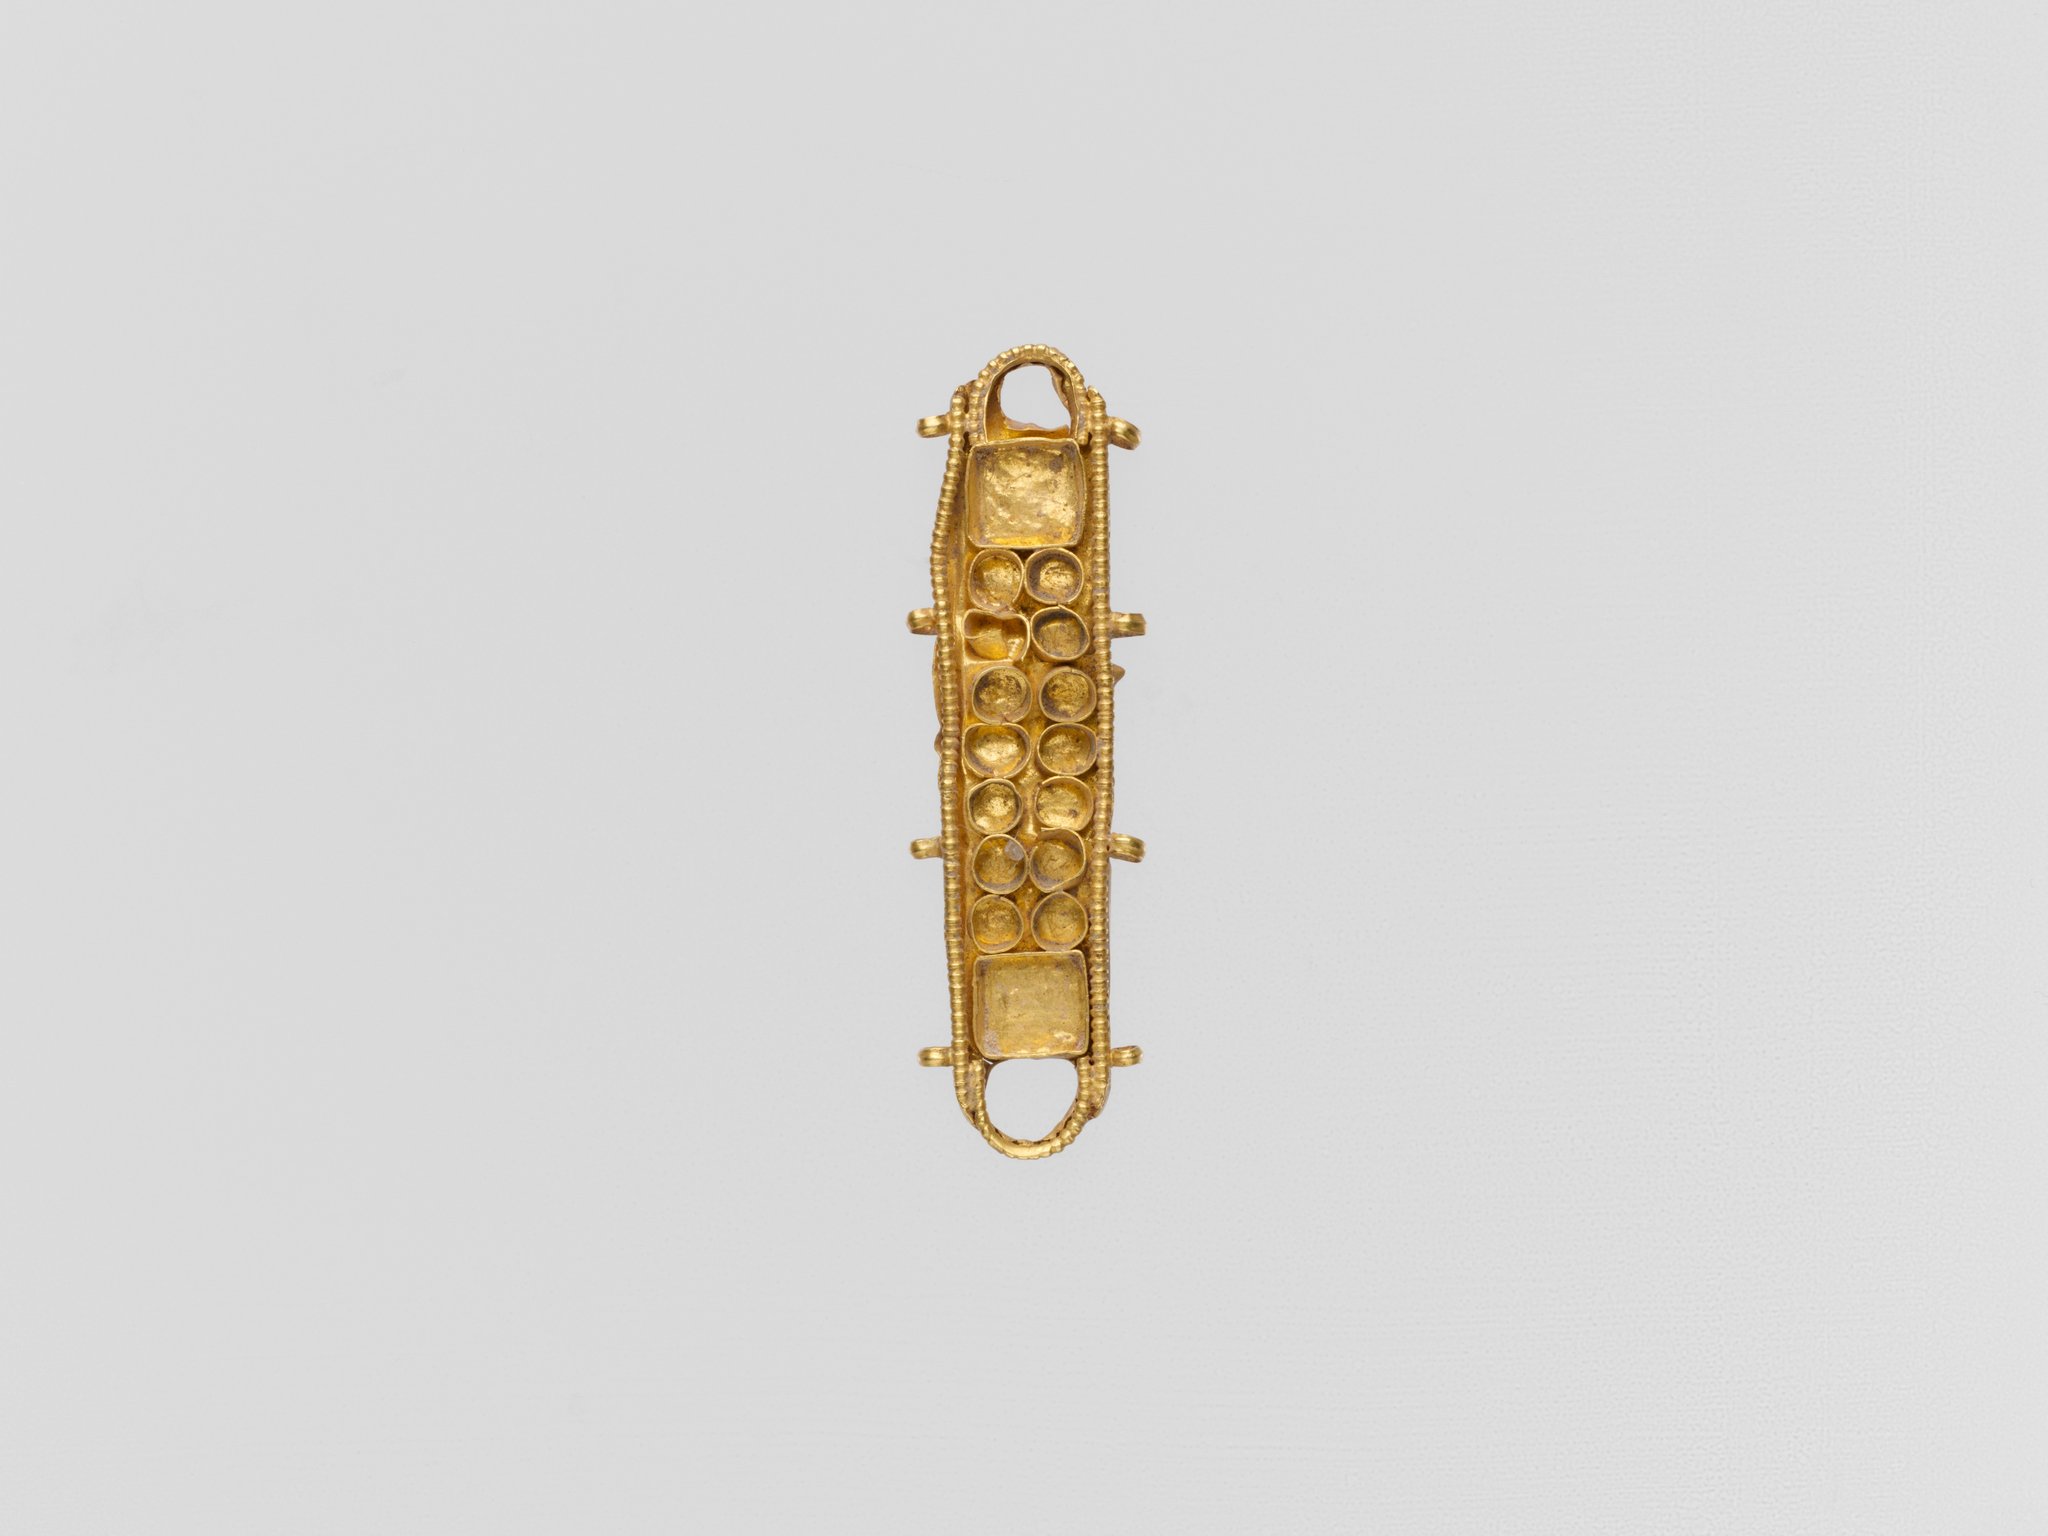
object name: bead ornament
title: Gold ornament with cloisons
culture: roman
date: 201-400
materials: gold